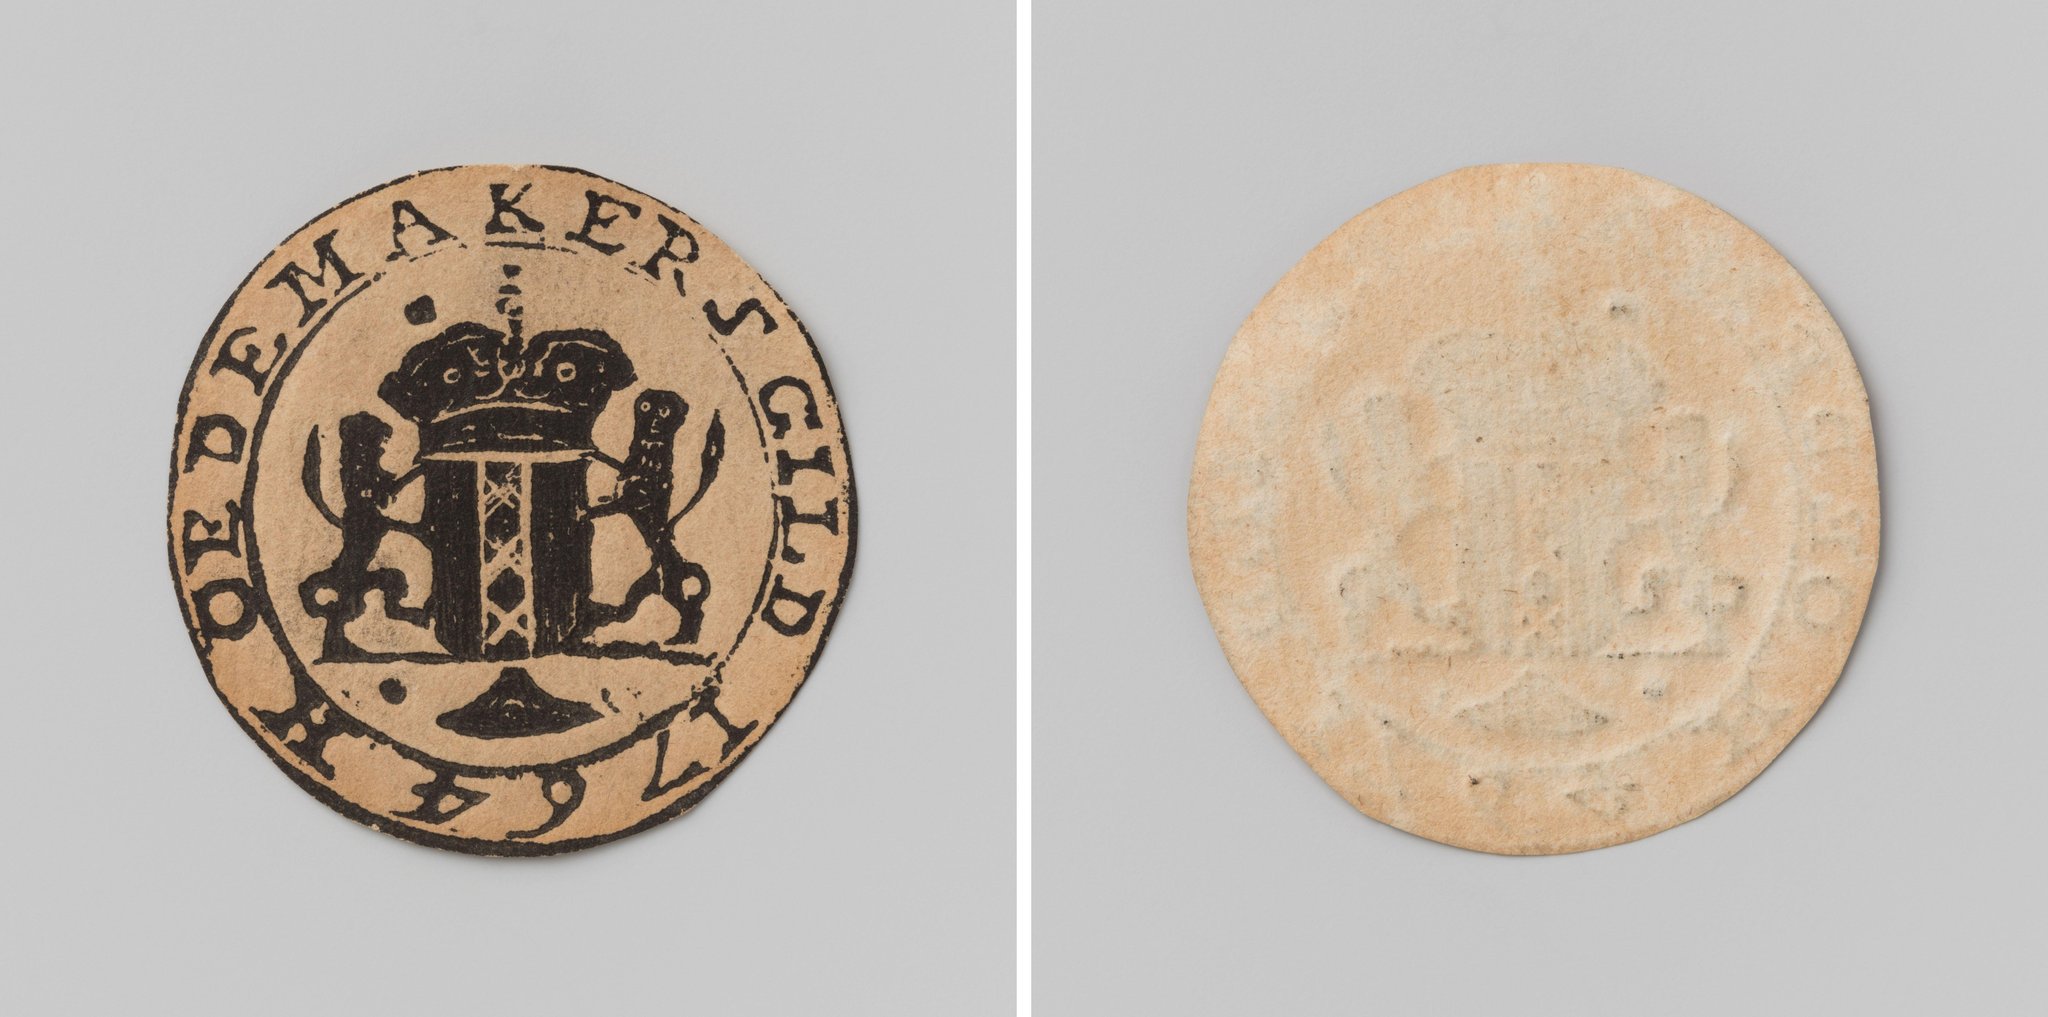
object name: medal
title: Afbeelding van gildepenning [?] van het hoedemakersgilde te Amsterdam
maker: Anonymous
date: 1674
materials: paper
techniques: printing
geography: amsterdam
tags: amsterdam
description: Eenzijdige afbeelding op papier; v.z: gekroond wapenschild, geflankeerd door twee leeuwen boven hoed binnen omschrift. Keerzijde: blanco.